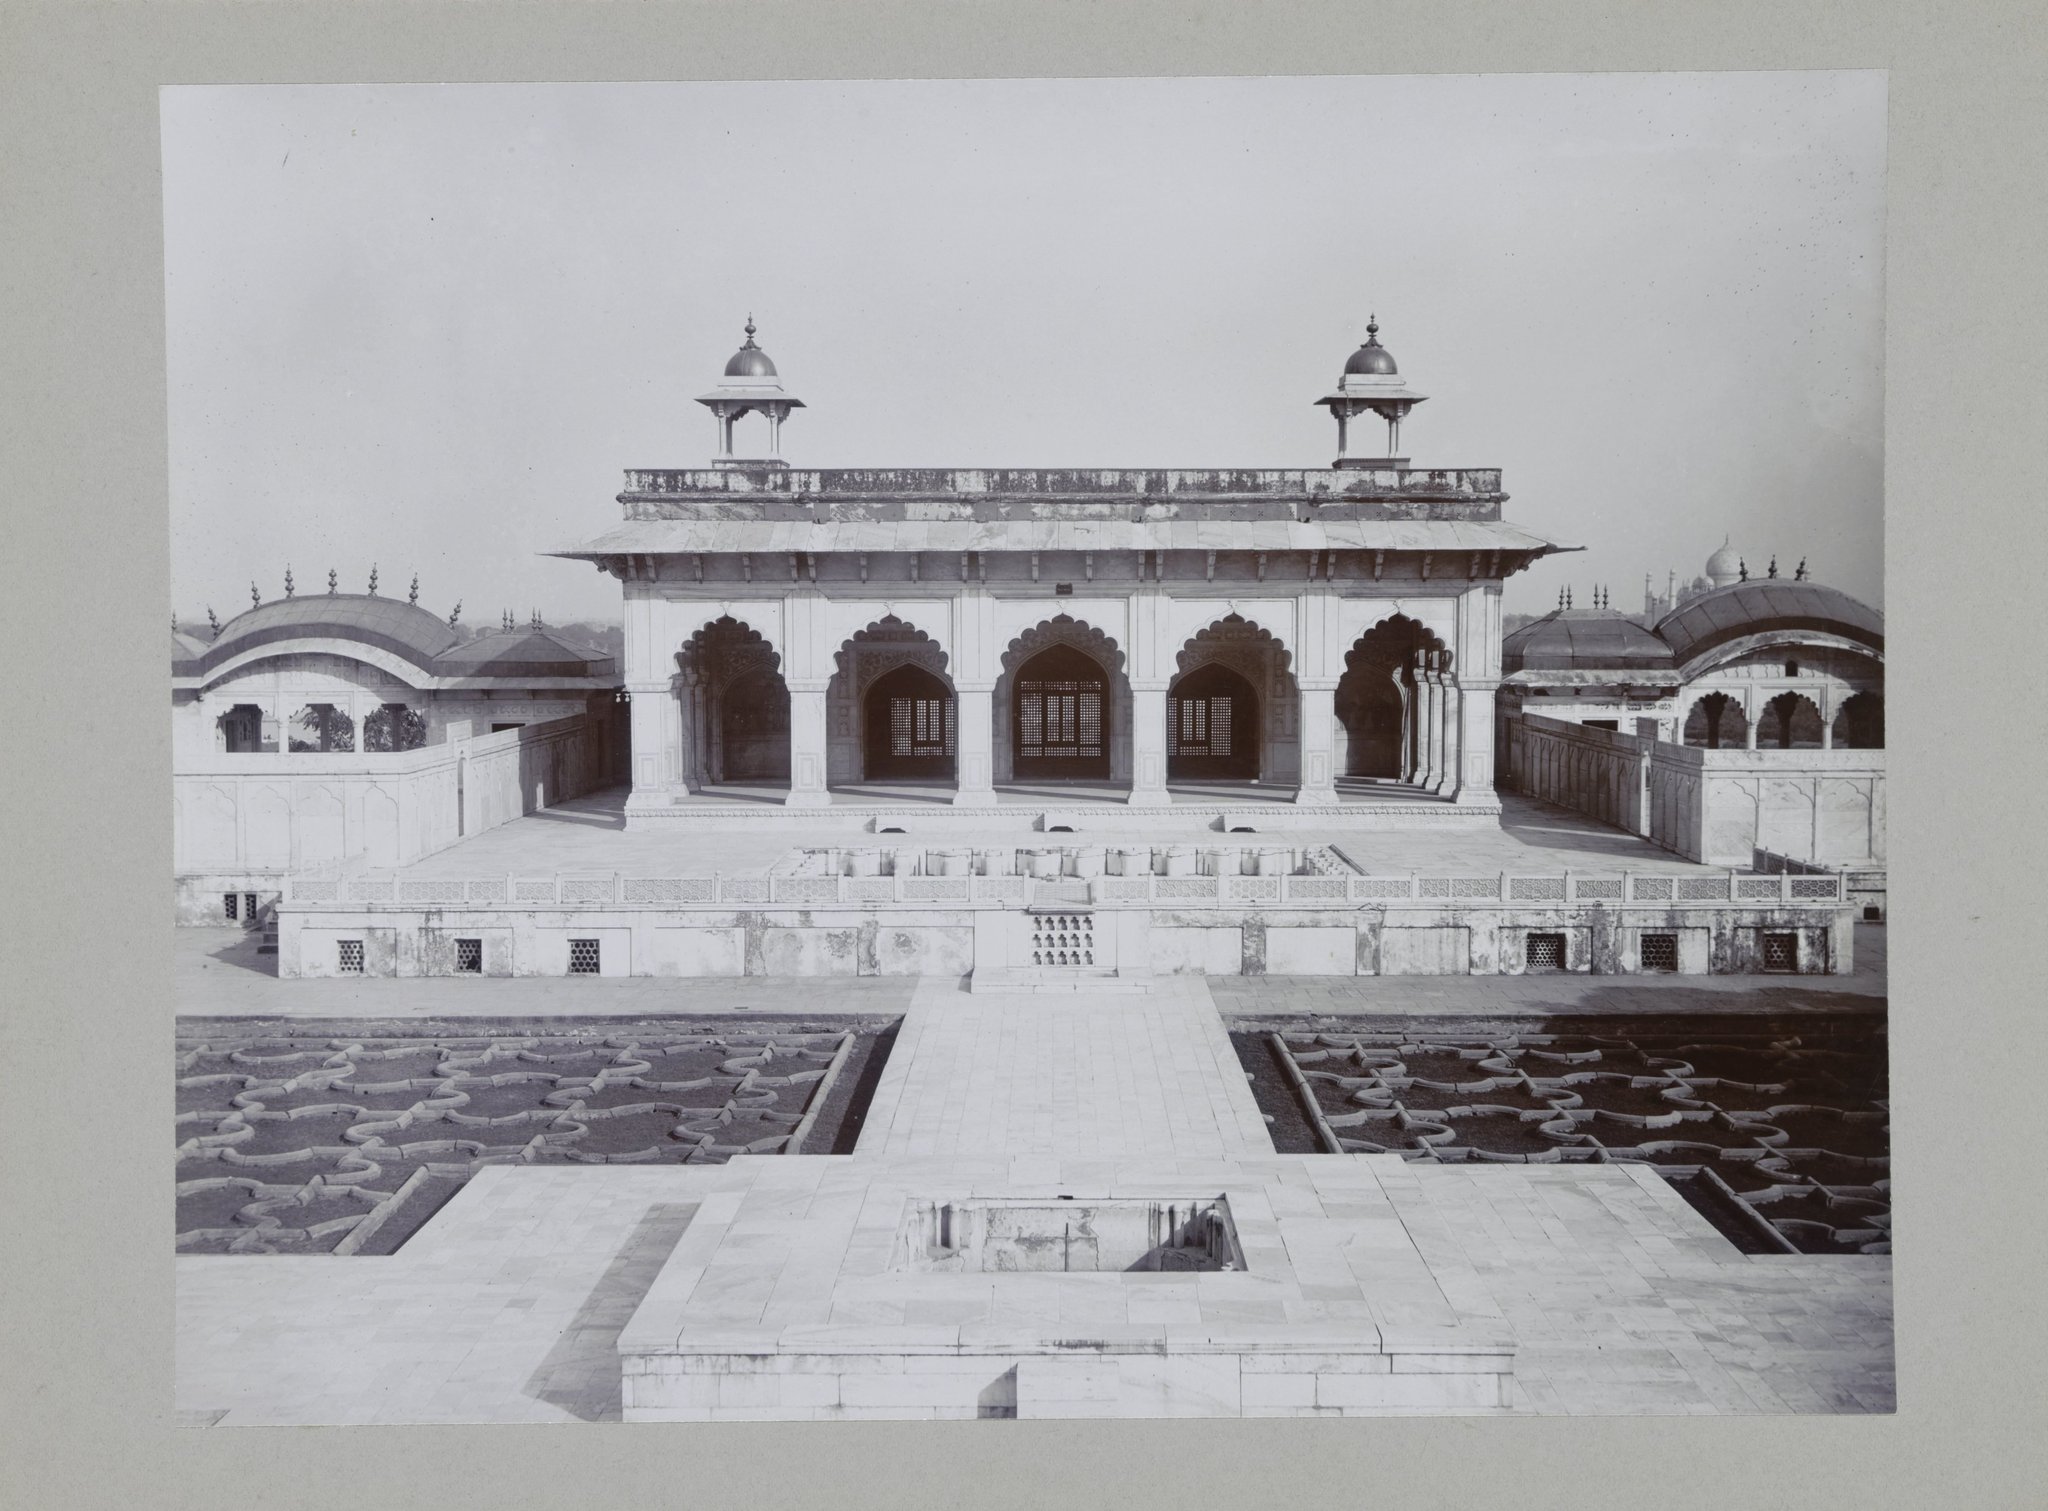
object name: photograph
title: Khas Mahal with the Grape Garden (Anguri Bagh) in the foreground in the Agra Fort, Uttar Pradesh, India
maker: Anonymous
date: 1895-1915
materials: cardboard, paper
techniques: gelatin silver print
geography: agra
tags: agra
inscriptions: annotation: ‘65. Fort te Agra.’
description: Het paleis Khas Mahal, onderdeel van het Fort van Agra.